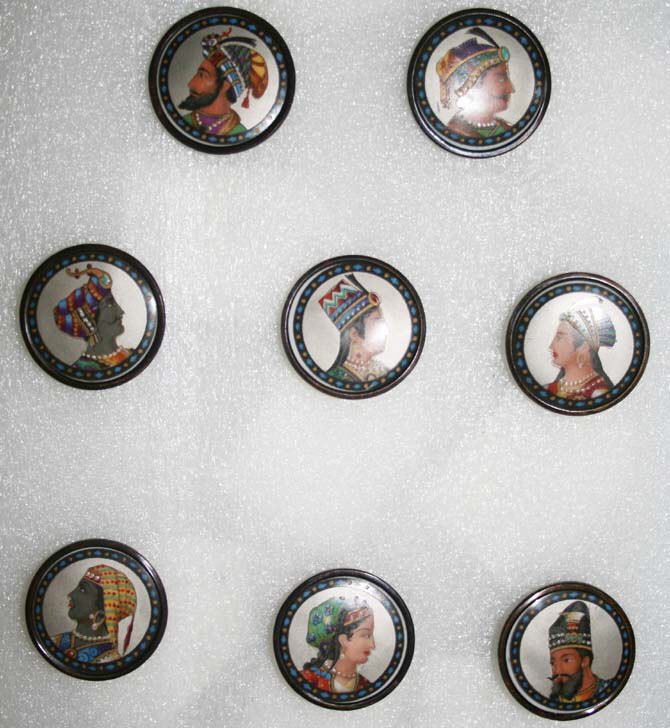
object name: button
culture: european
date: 1810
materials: metal, porcelain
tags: heads,men,portraits,women